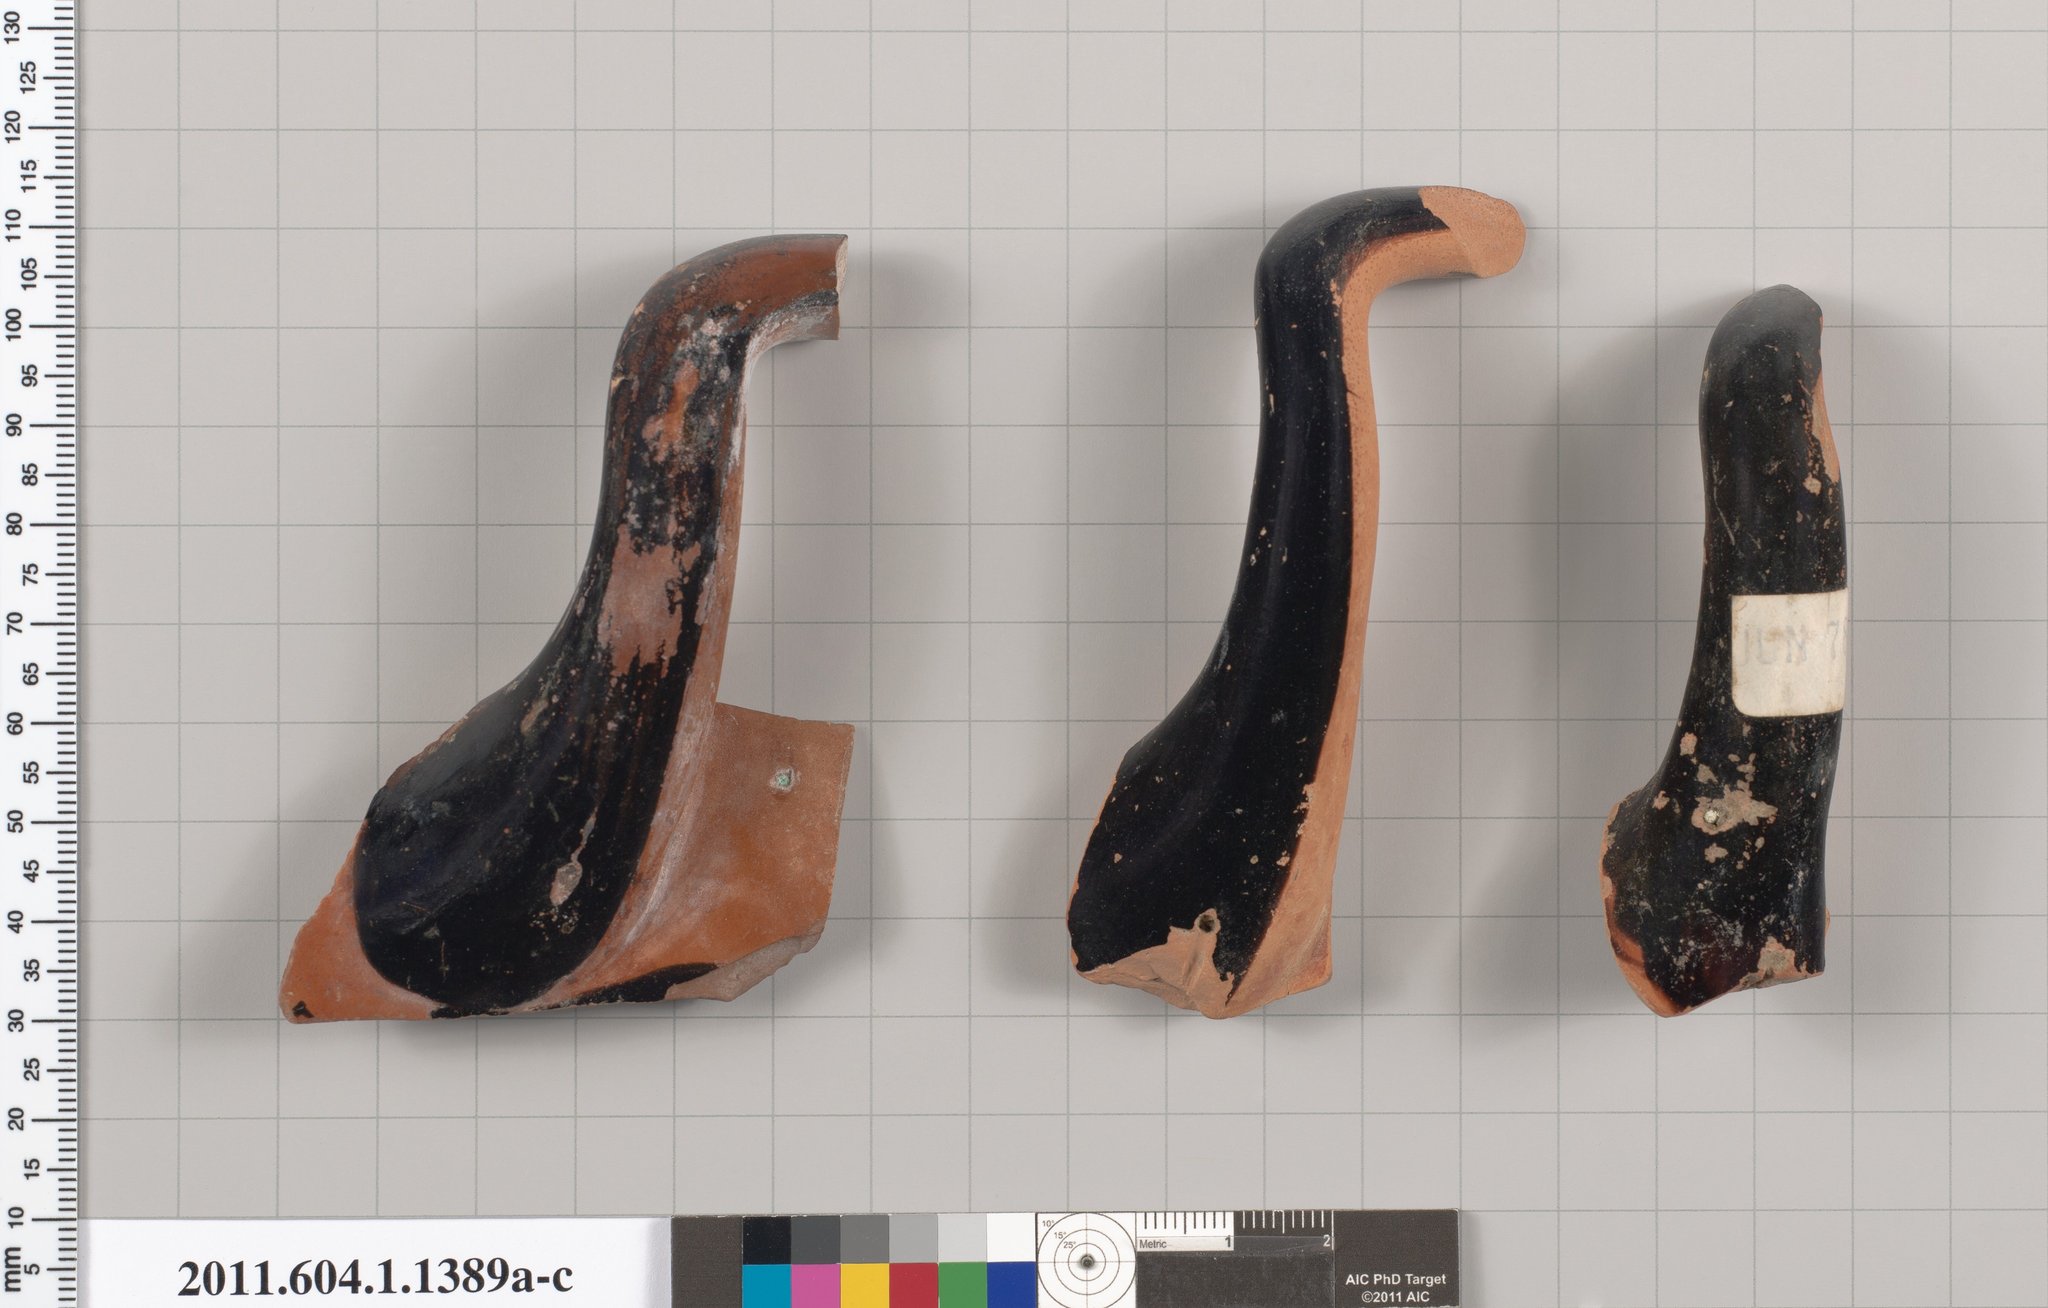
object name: kylix fragment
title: Terracotta fragments of kylikes (drinking cups)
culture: greek, attic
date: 500-401 BCE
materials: terracotta